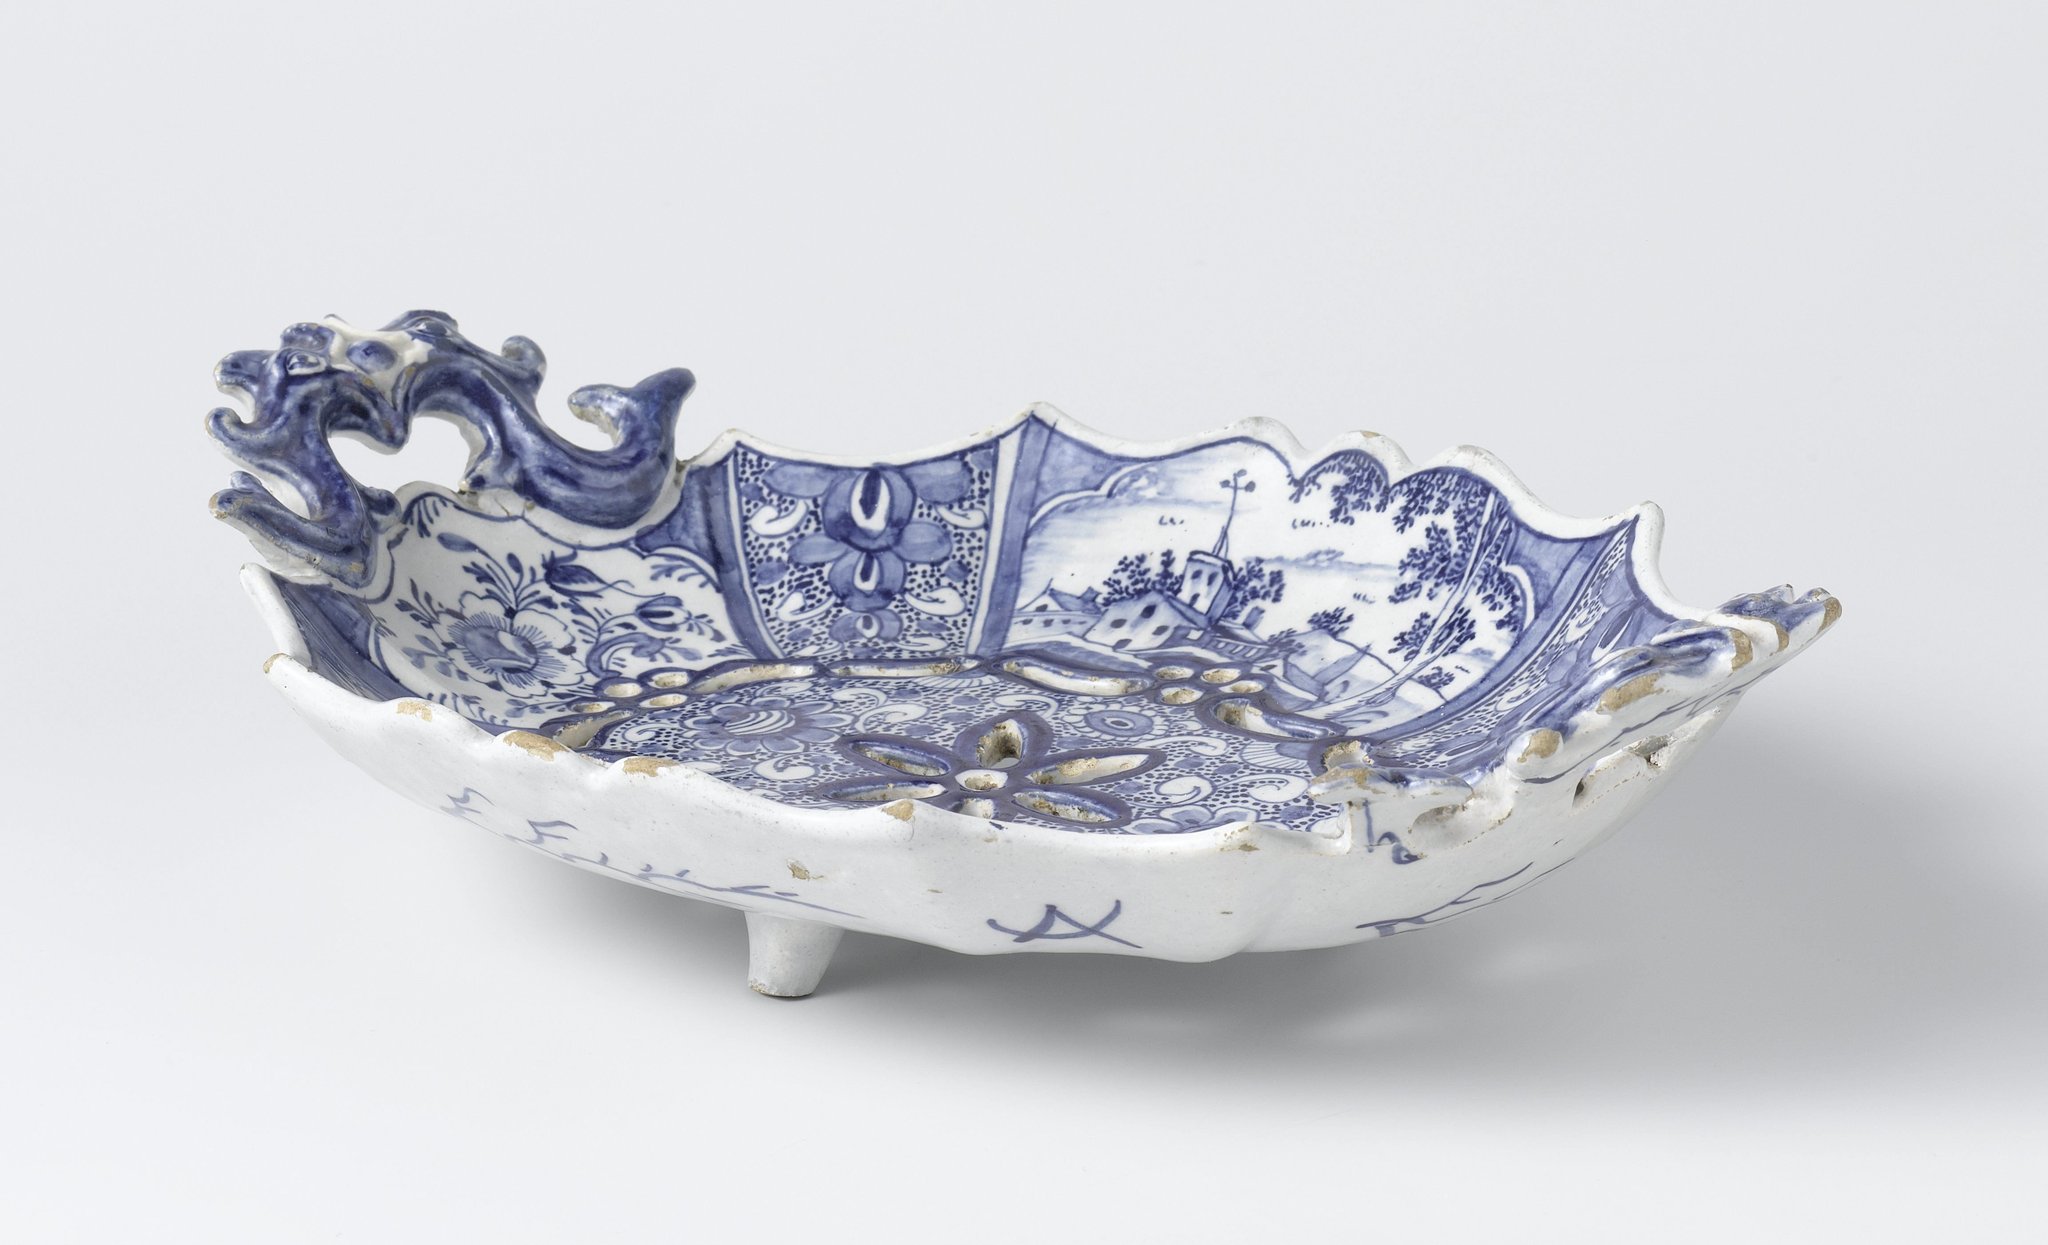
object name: vergiet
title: Natfruitschaal van faience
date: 1750-1780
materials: earthenware, glaze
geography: delft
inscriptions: mark: ‘148/ figuratief teken ster’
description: Blauw beschilderd met bloemen en landschappen in medaillons. Hoort bij onderschotel NM-4447.